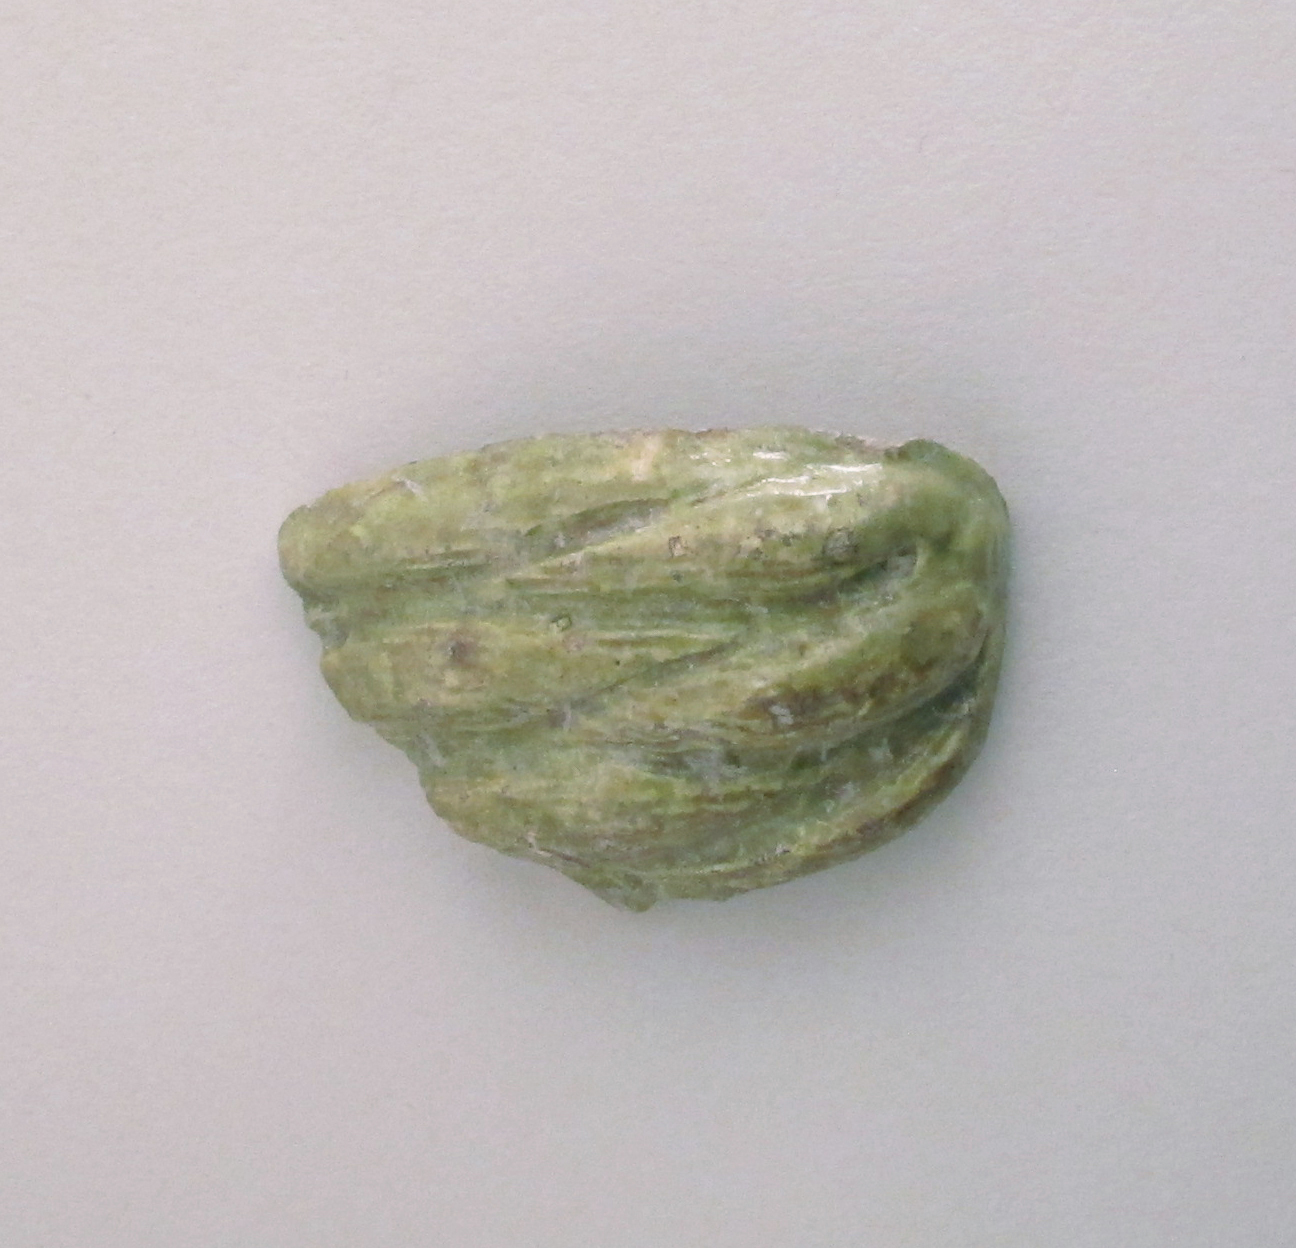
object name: vase fragment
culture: roman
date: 670 BCE-330 CE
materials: terracotta